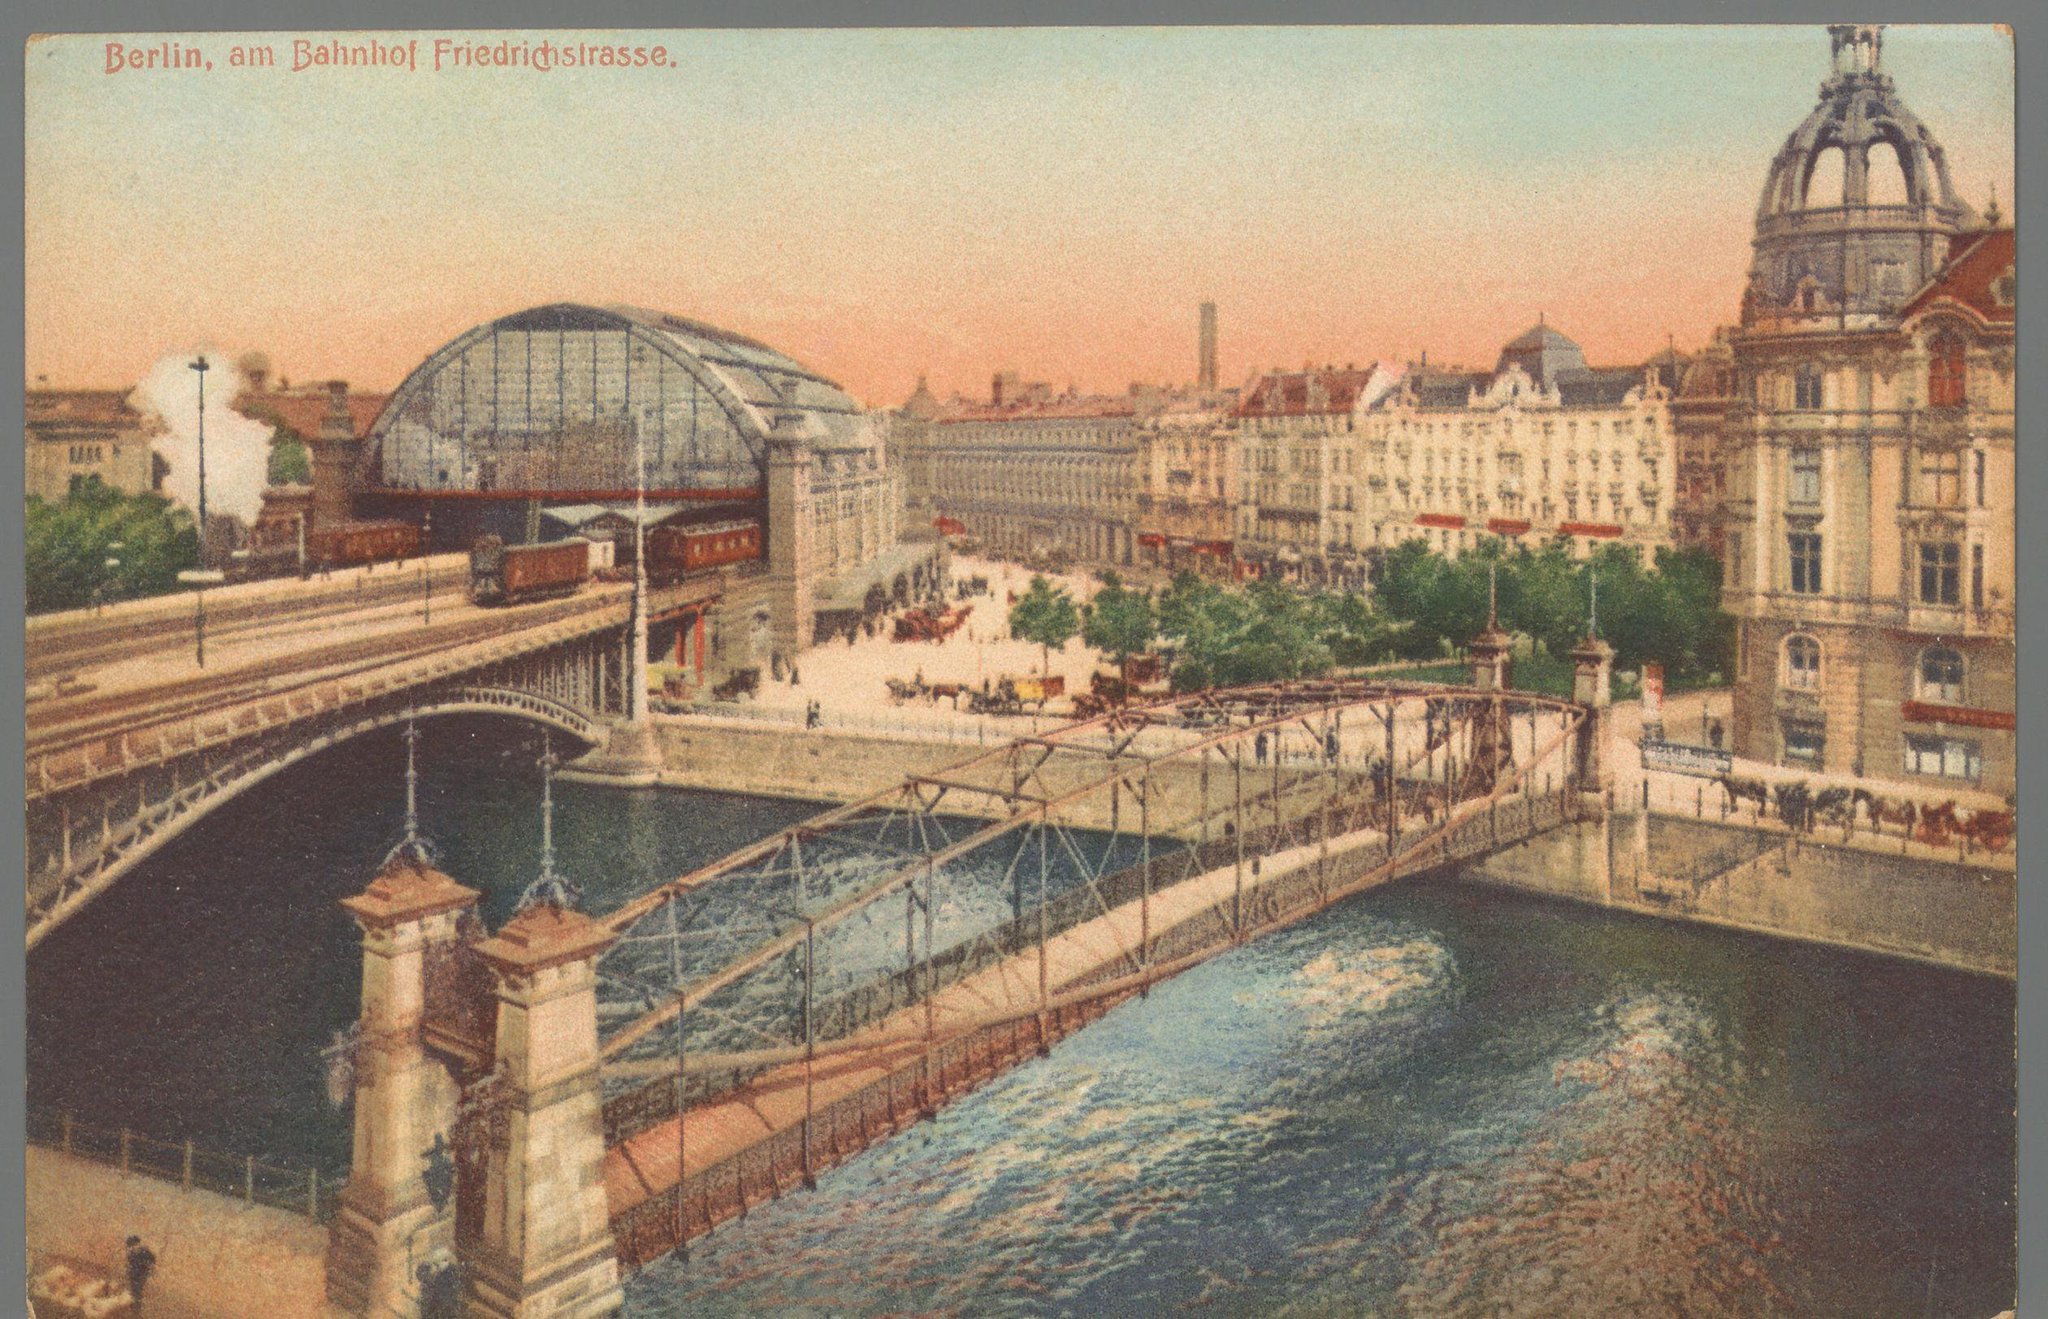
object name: ansichtkaart, prentbriefkaart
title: Berlin, am Bahnhof Friedrichstrasse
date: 1905-1909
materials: cardboard, photographic process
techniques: writing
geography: berlin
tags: canals, waters (in city), railway, train, station; shelter (railway, tramway), bridge in city across river, canal, etc.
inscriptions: monogram: ‘A.S.B.’